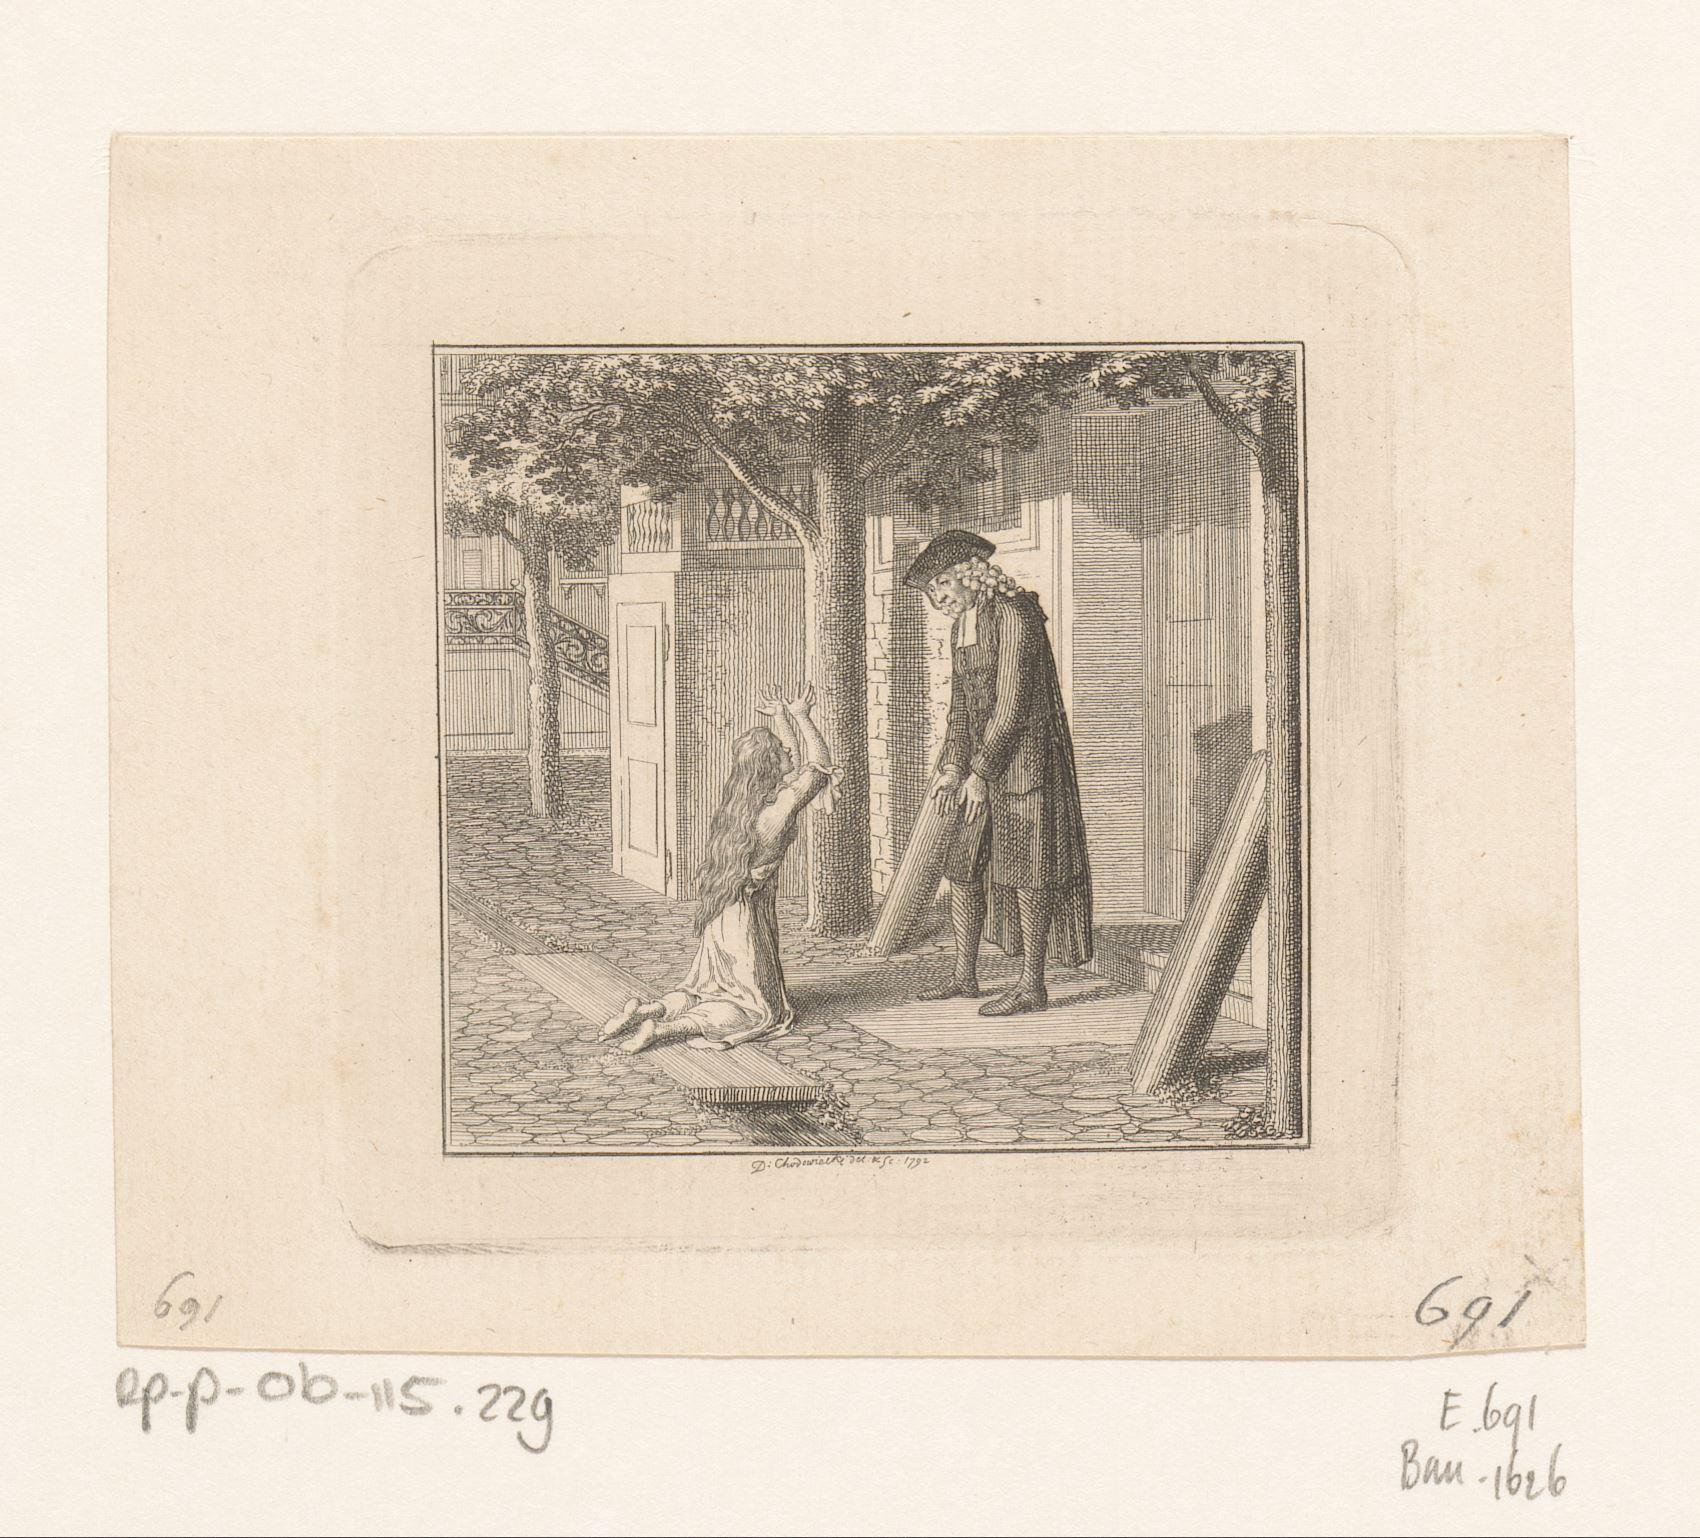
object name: print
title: Luise smekend aan de voeten van de prediker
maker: daniel nikolaus chodowiecki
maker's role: draughtsman, print maker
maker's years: 1726-1801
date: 1792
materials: paper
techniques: etching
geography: berlin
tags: literature, kneeling figure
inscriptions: collector's mark: Lugt 2228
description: Prent gebruikt voor: Demme, Hermann Christian Gottfried. Pächter Martin und sein Vater. 3 dln. Leipzig: Georg Joachim Göschen, 1792, dl. 1.